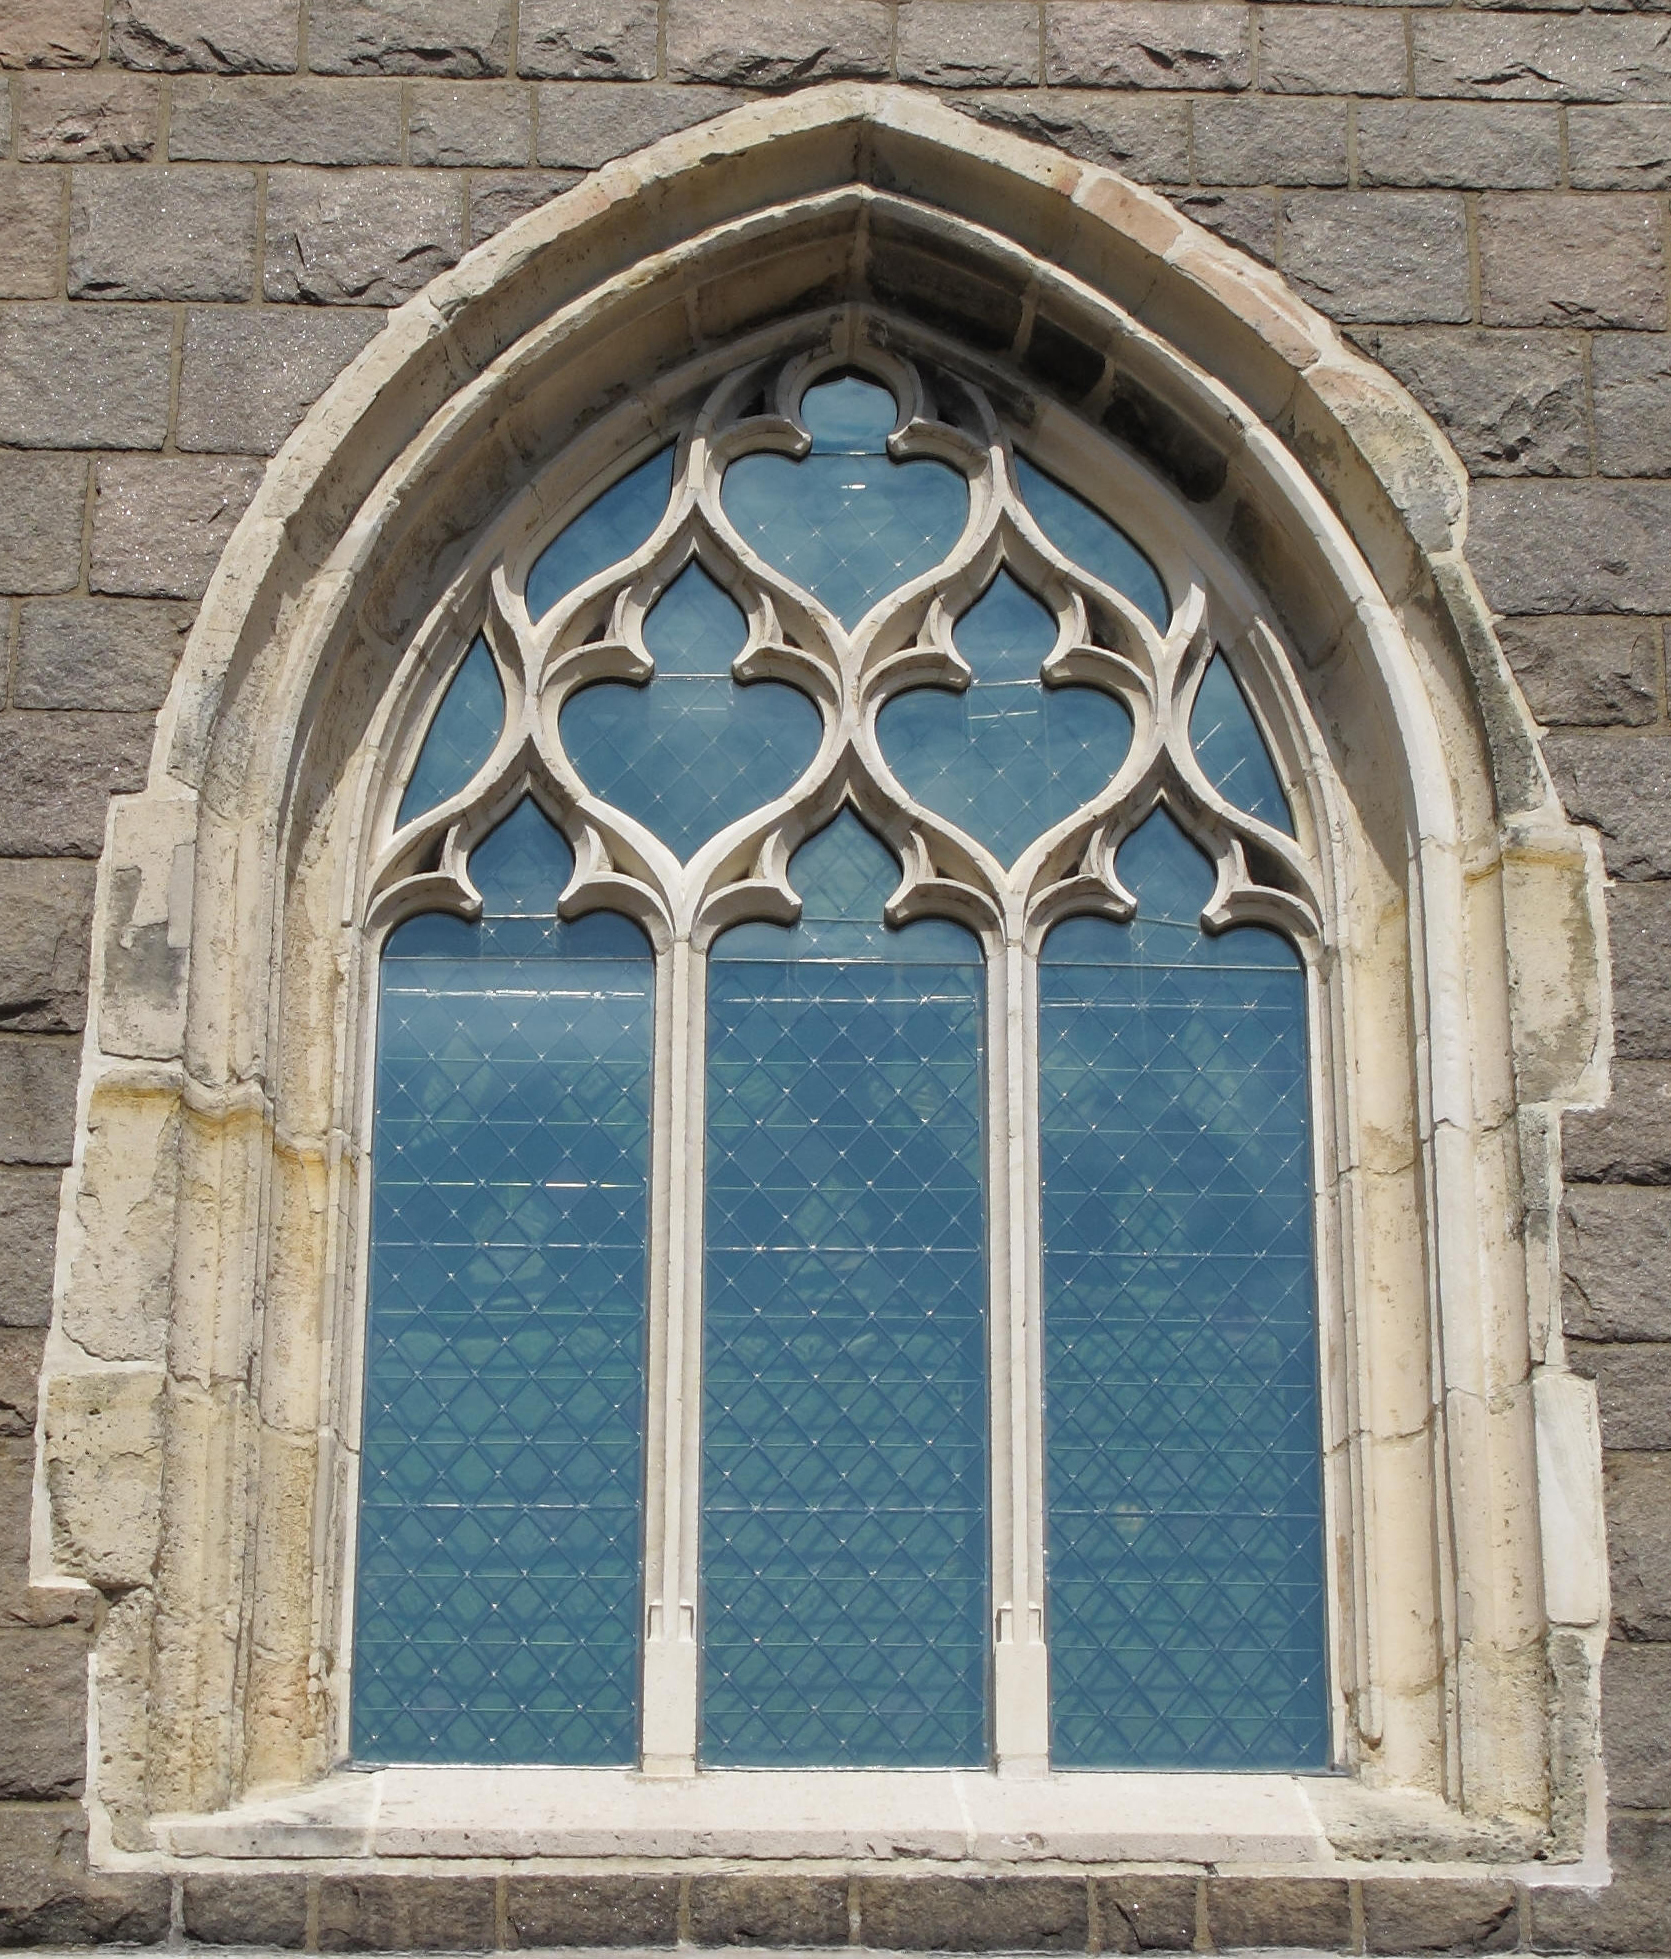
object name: window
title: Window with Flamboyant Tracery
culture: french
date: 1401-1500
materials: limestone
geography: france